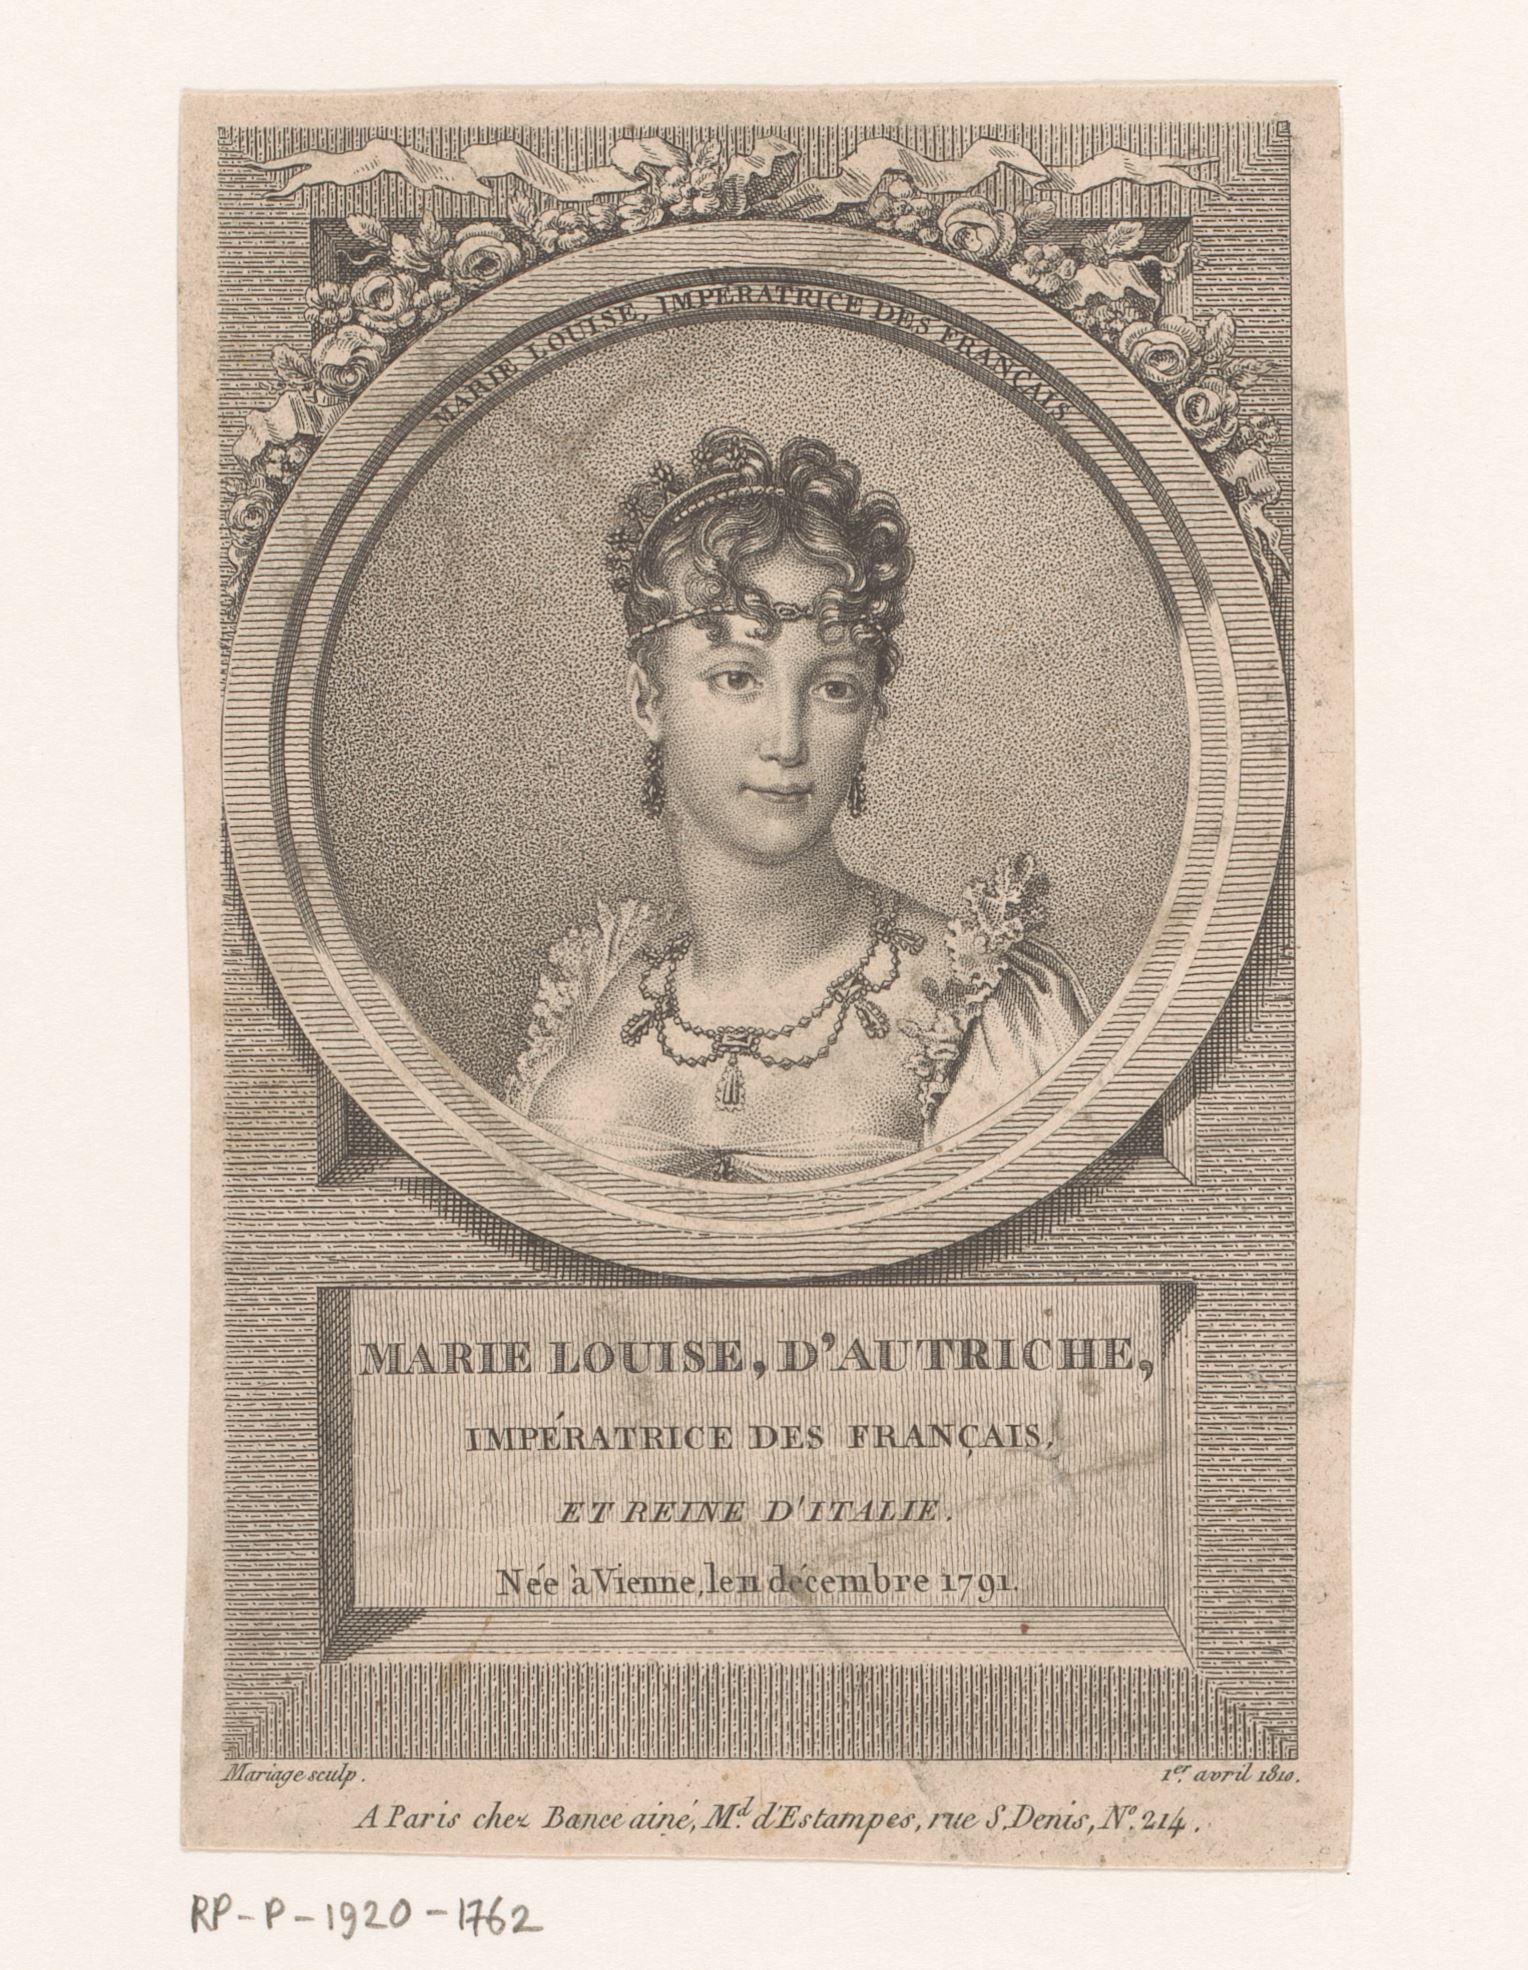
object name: print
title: Marie Louise, d'Autriche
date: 1810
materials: paper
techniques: etching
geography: paris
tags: marie louise van oostenrijk (keizerin der fransen), historical persons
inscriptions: collector's mark: Lugt 2228